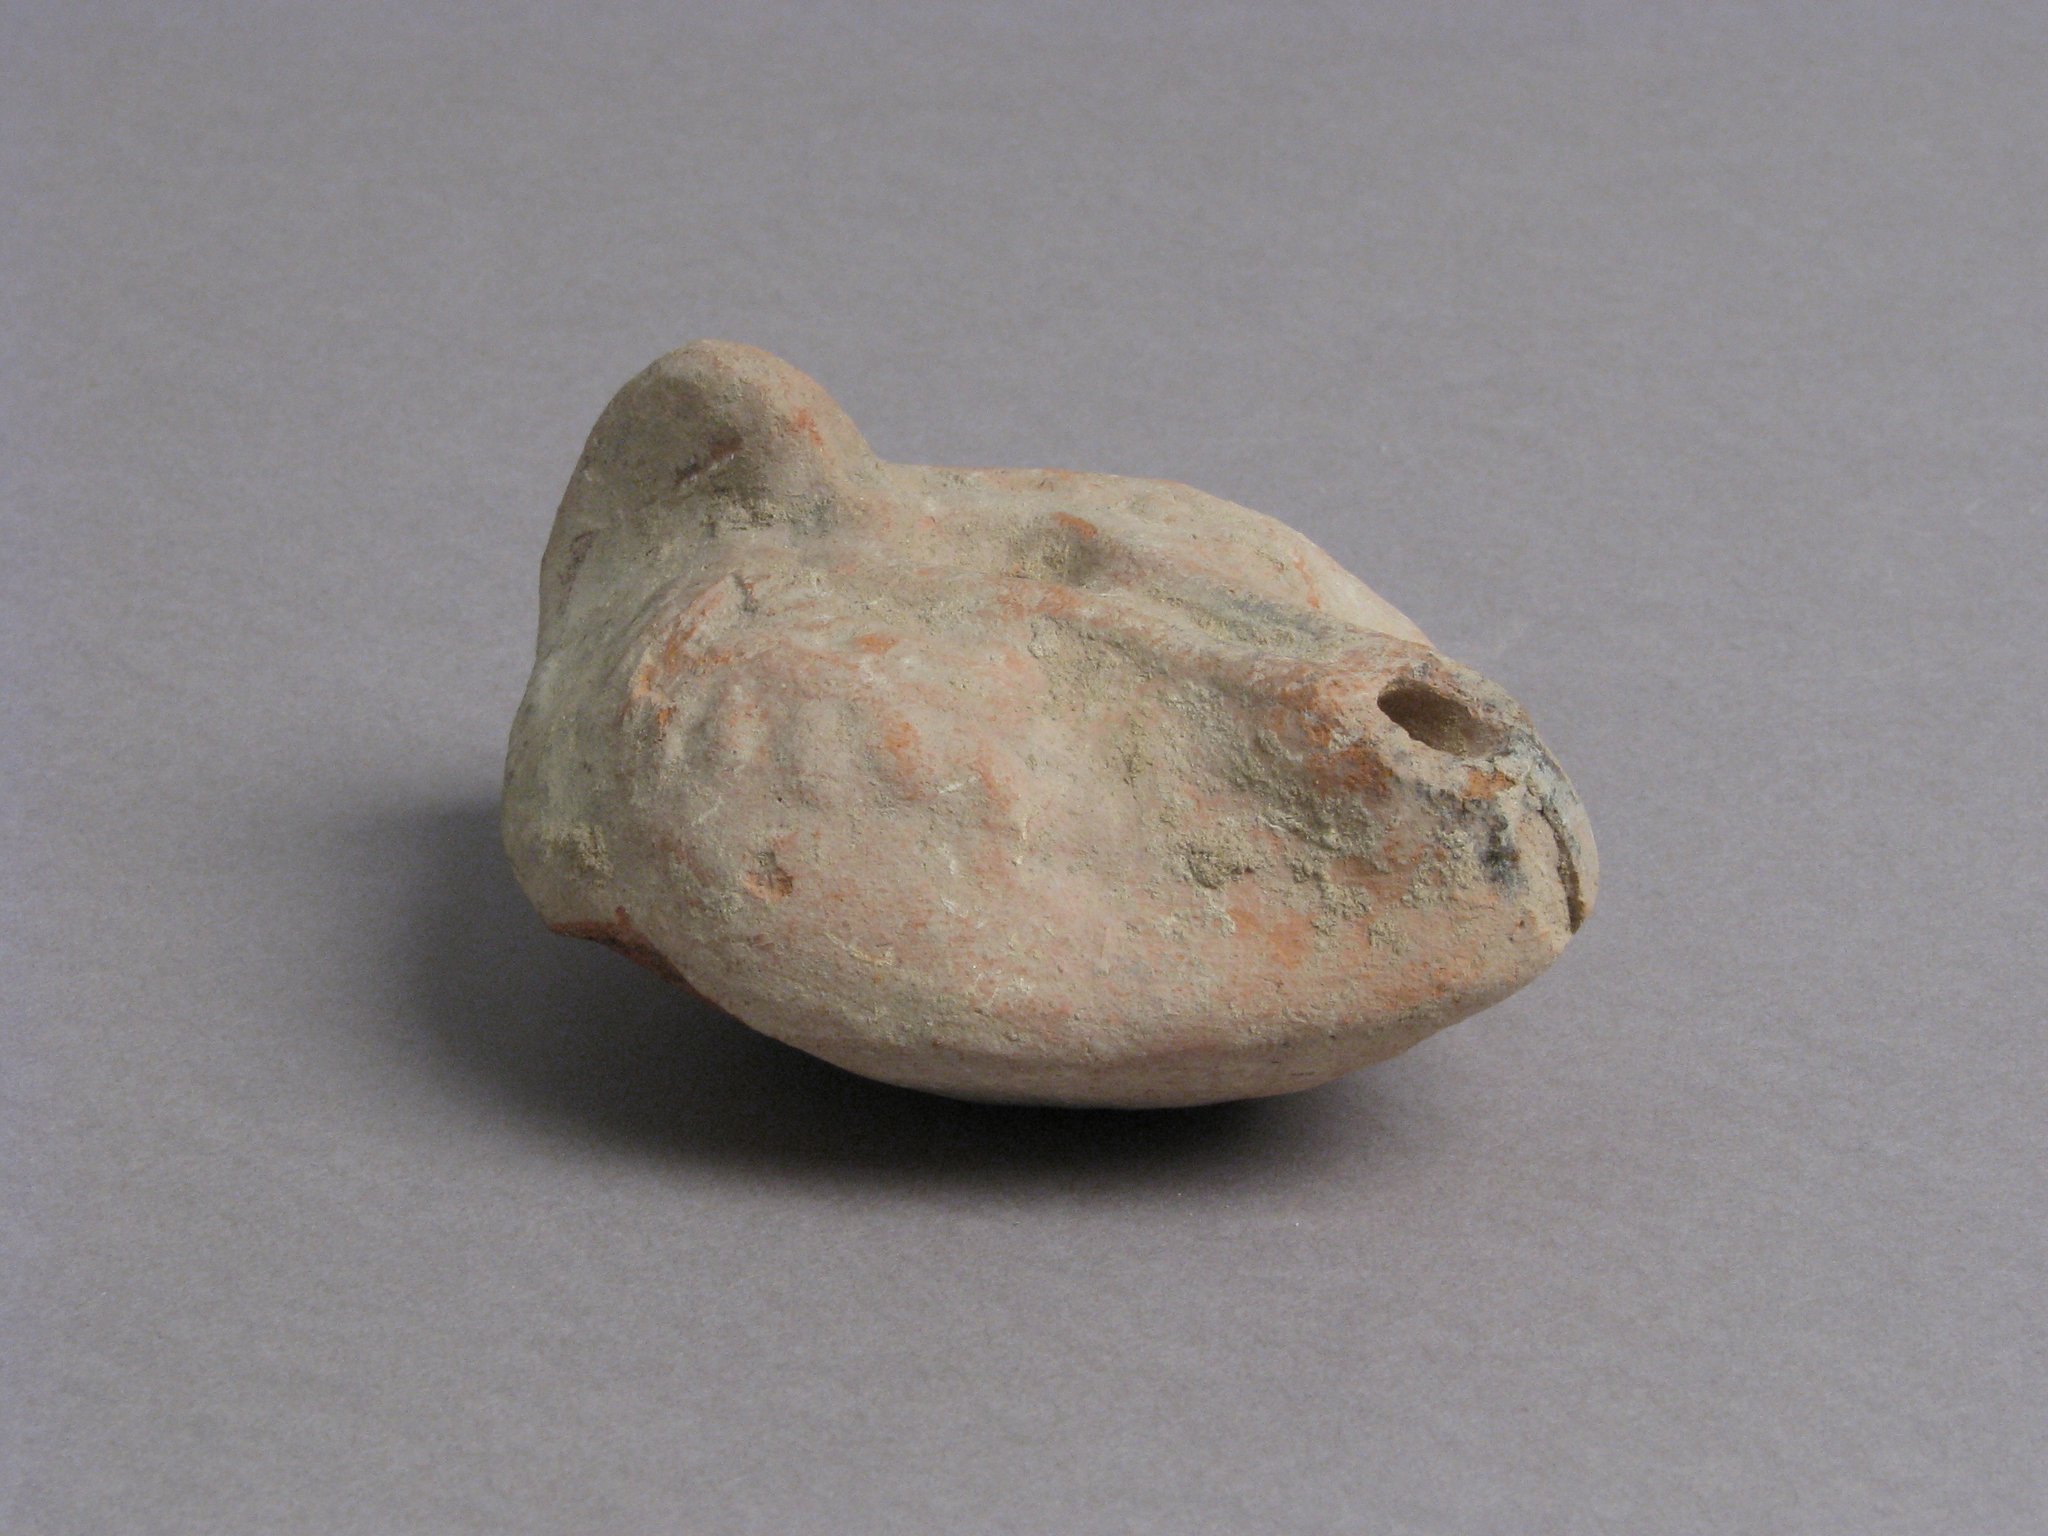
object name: lamp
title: Oil Lamp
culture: coptic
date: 301-700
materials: earthenware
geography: egypt